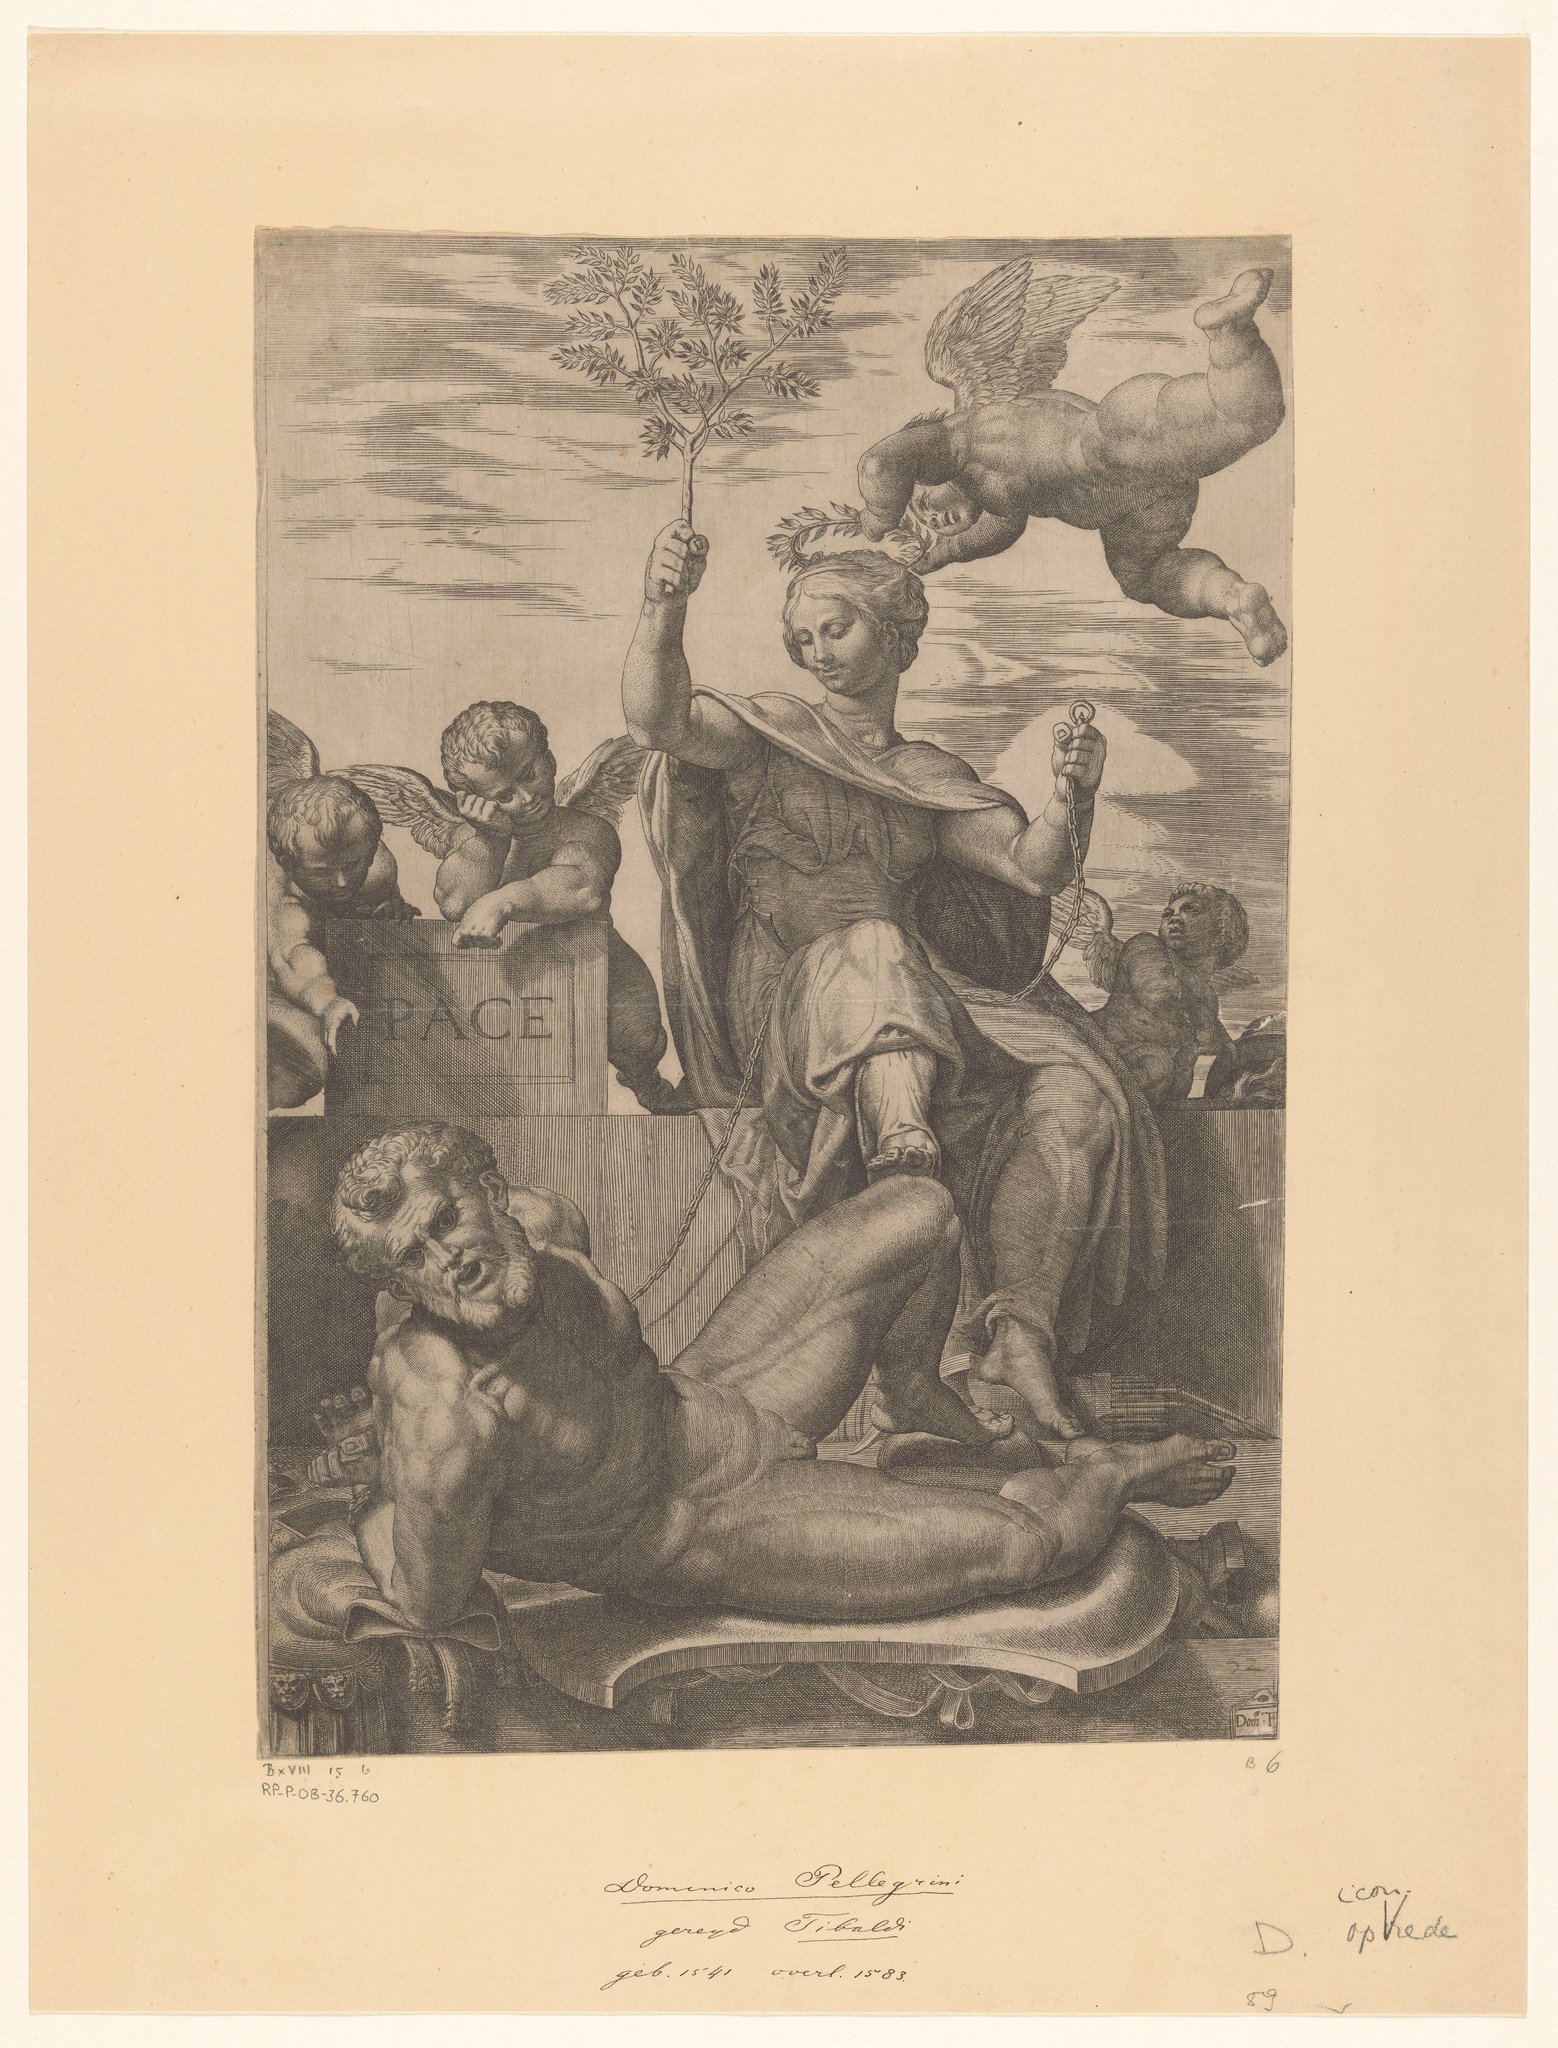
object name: print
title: Vrede (Pax)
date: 1551-1583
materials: paper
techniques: engraving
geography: italy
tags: symbols, allegories of peace, 'pax'; 'pace' (ripa), cupids: 'amores', 'amoretti', 'putti', tools, aids, implements ~ crafts and industries: chain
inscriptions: collector's mark: Lugt 789a, number: ‘52’, collector's mark: Lugt 240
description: De Vrede (Pax) als vrouw, zittend met in de ene hand een olijftak en in de andere hand een keten. De keten bindt de handen bijeen van een naakte man die op de voorgrond ligt. Om de vrouw heen vier putti, één waarvan een olijfkroon vasthoudt.